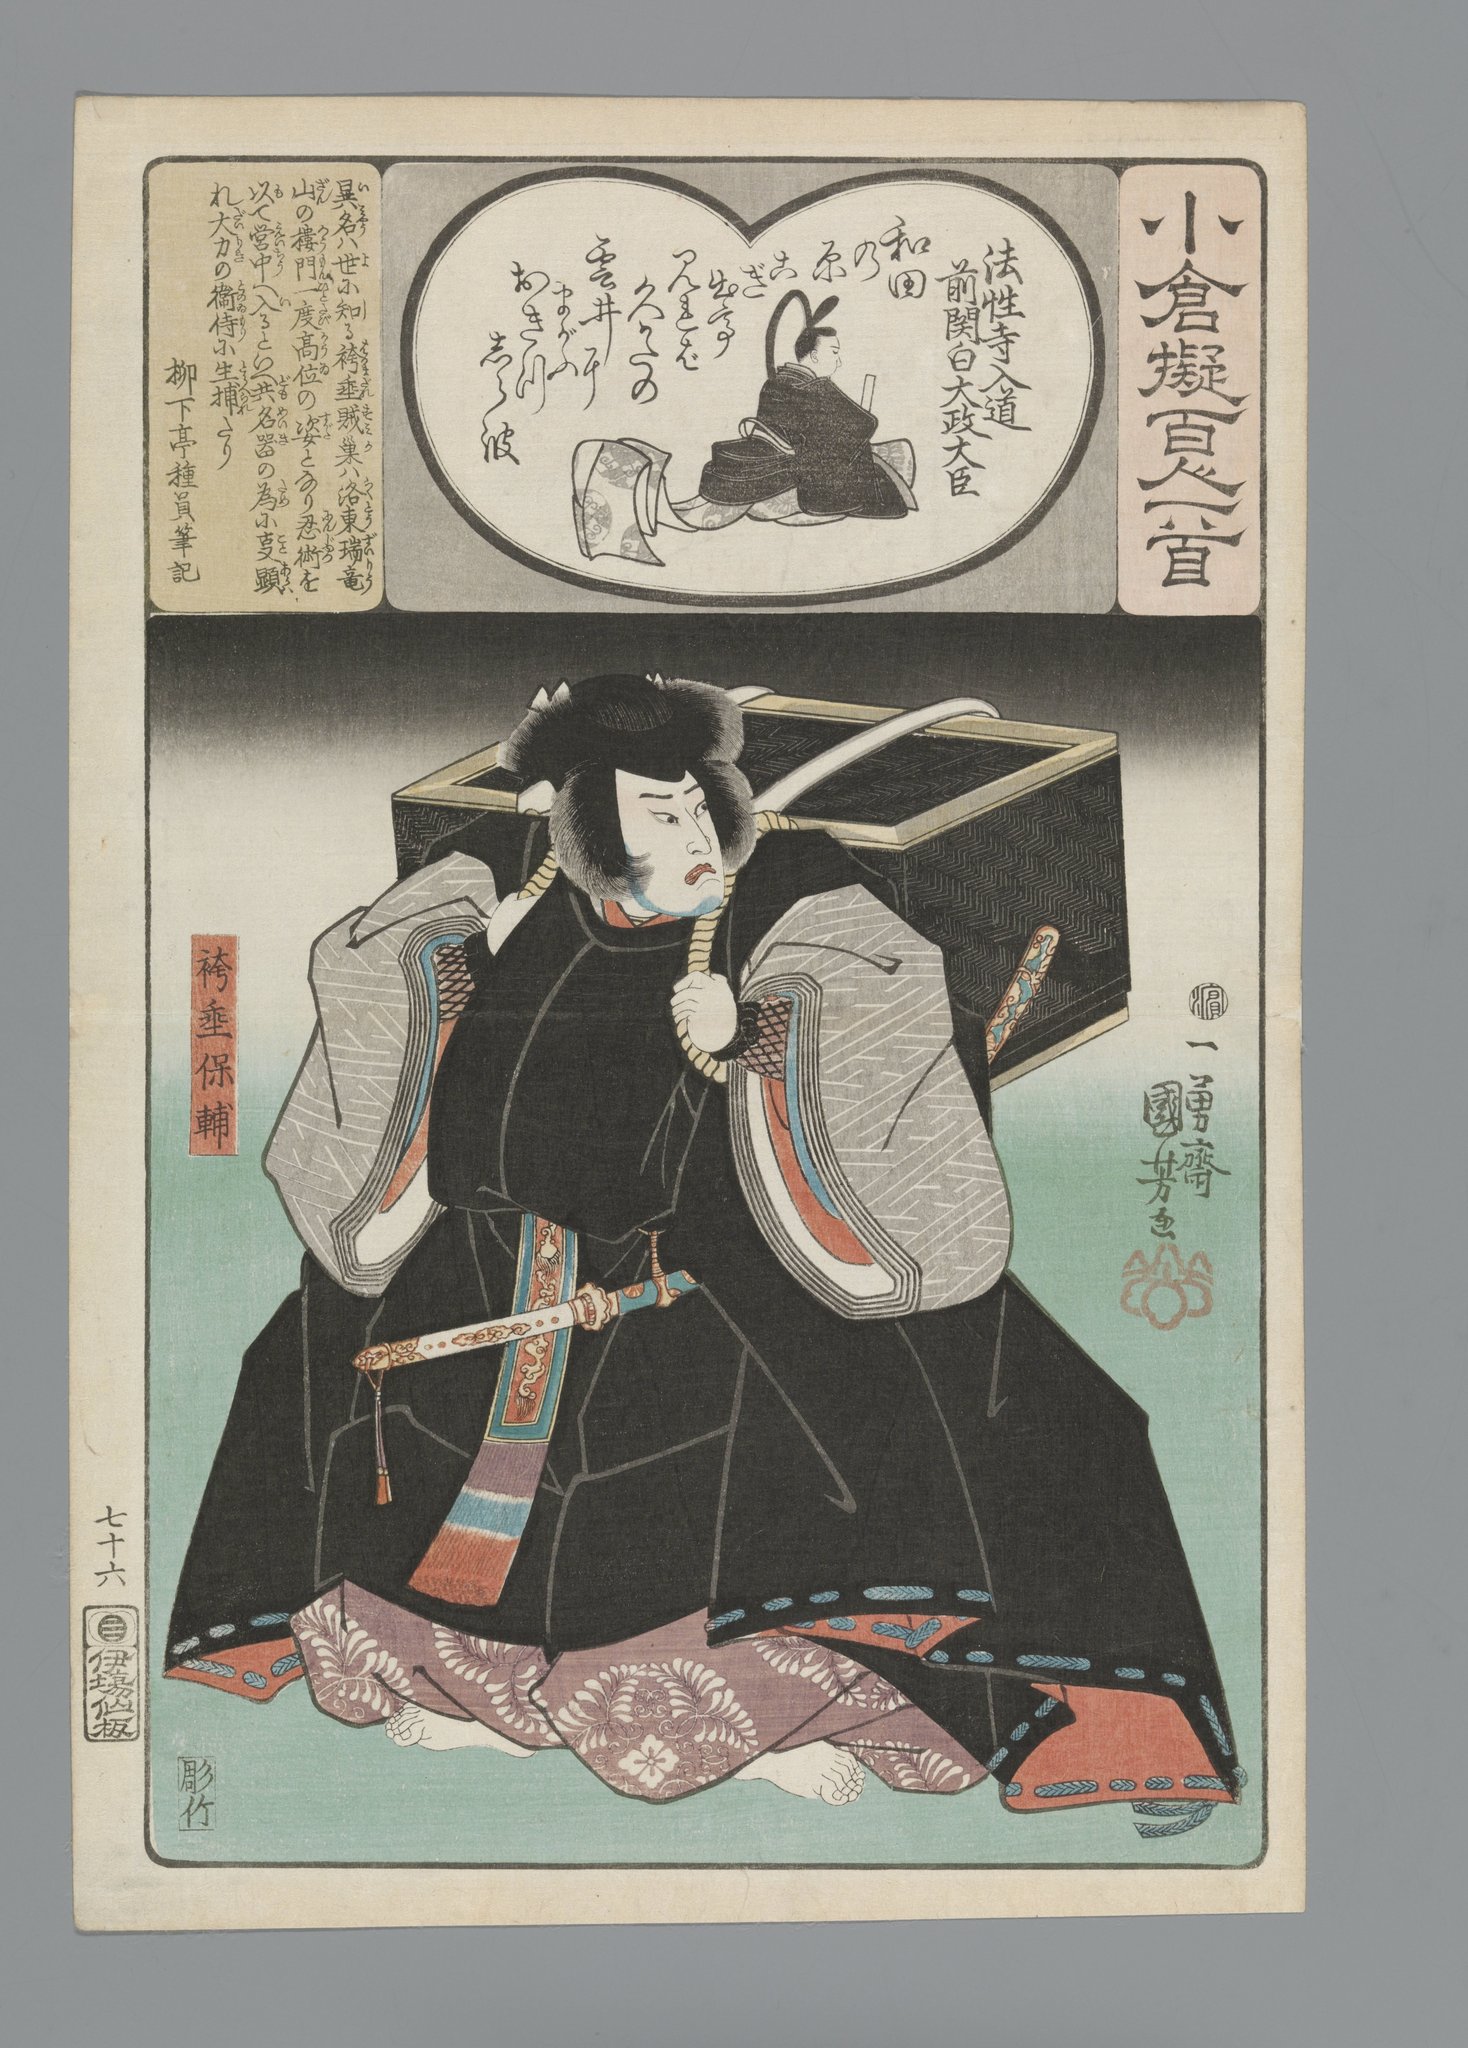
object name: print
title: Ogura Imitation of the One Hundred Poems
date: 1845-1848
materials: paper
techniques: woodcut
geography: japan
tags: carrying something, thief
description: De dief Hakamadara Yasusuku in gestolen kleding en op zijn rug een kist waarin zijn buit zit. Scene uit een kabukitoneelstuk. Gedicht door Fujiwara no Tadamichi.